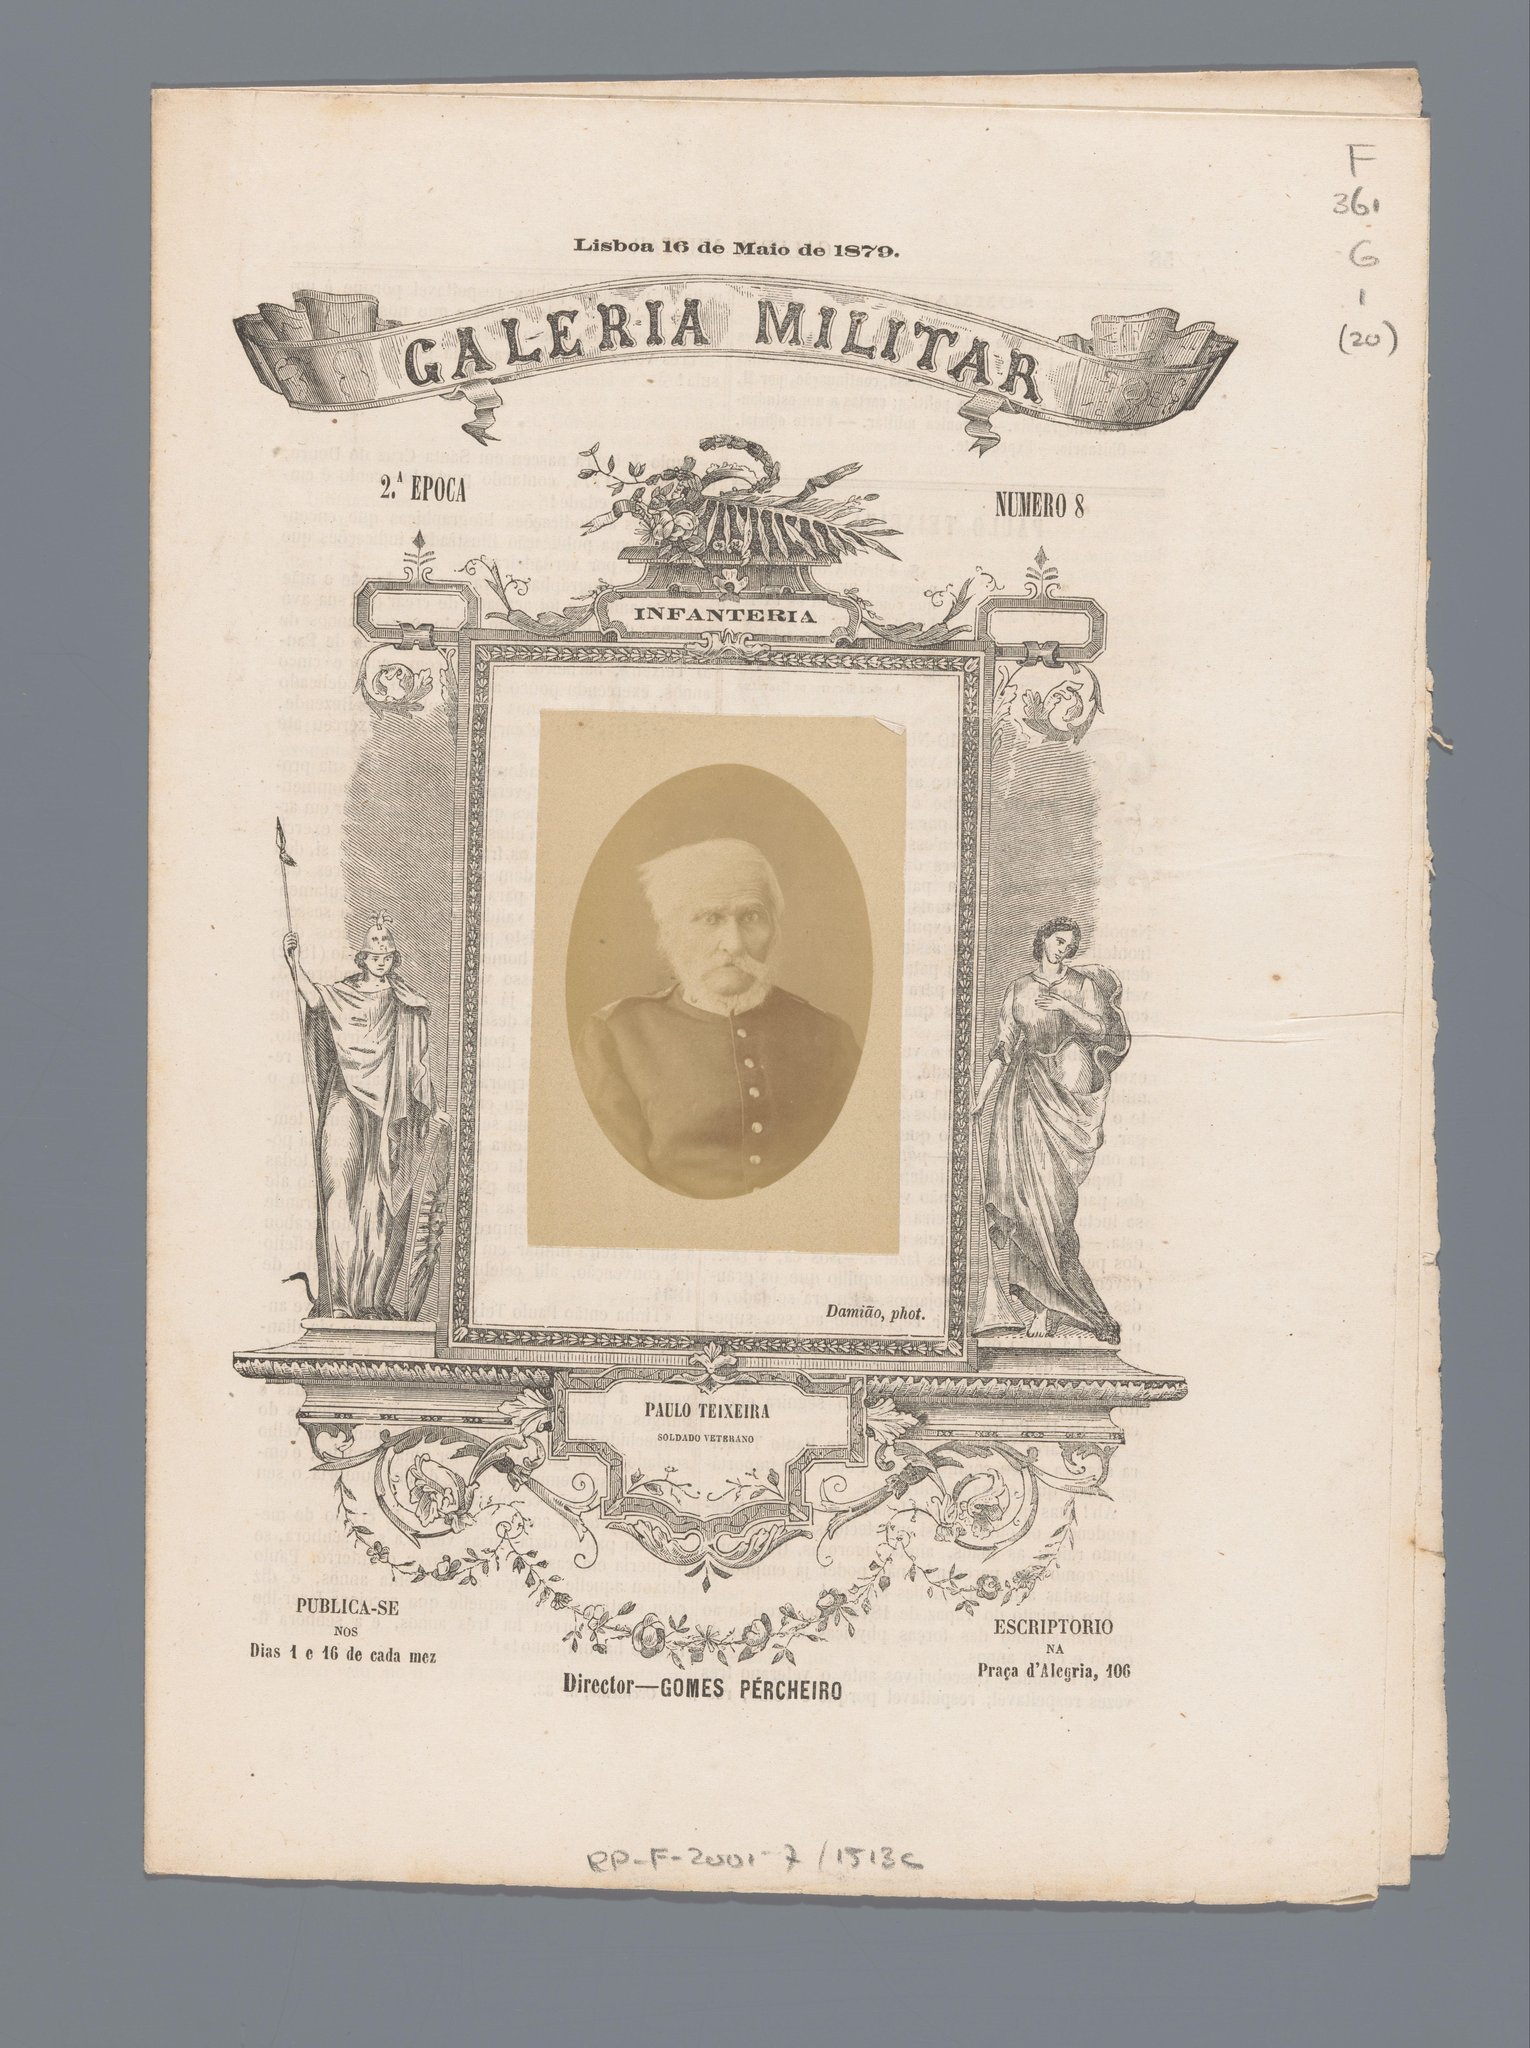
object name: book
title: Galeria militar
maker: gomes pércheiro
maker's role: publisher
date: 1879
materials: paper, photographic support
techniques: albumen print, printing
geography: lisbon